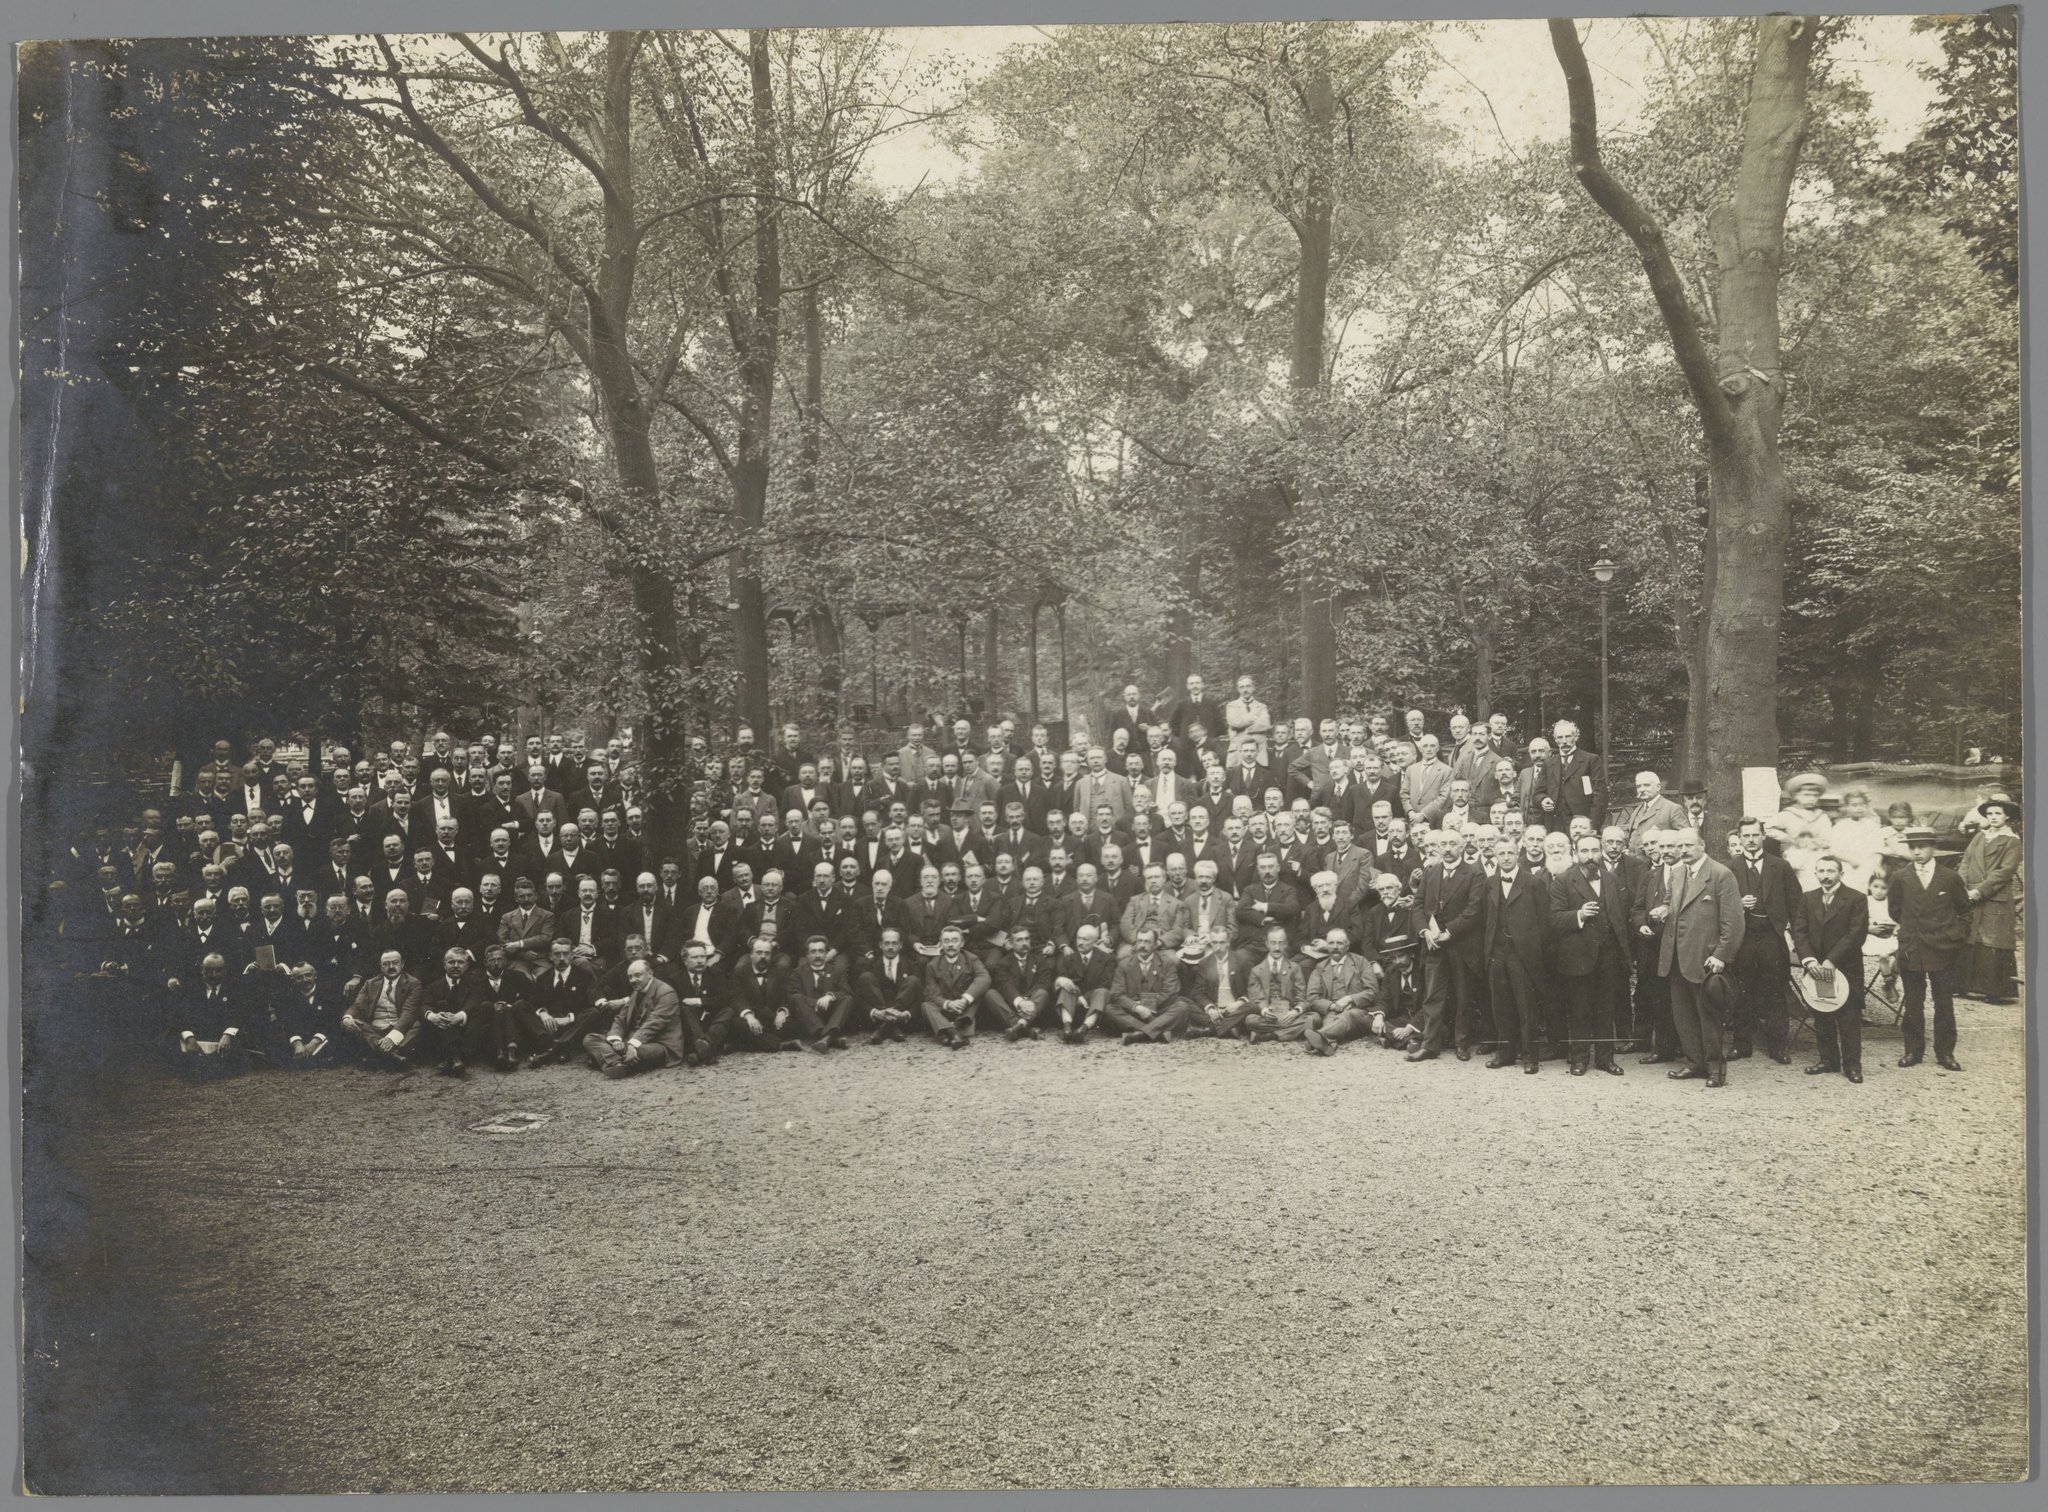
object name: photograph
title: Vereniging t.b.v. de Boekhandel, groepsportret Artis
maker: Anonymous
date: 1915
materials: photographic support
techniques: gelatin silver print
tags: artis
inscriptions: inscription: ‘In Artis, 100 jarig bestaan Ver. t.b. v.d. Boekhandel 12 augustus 1915’